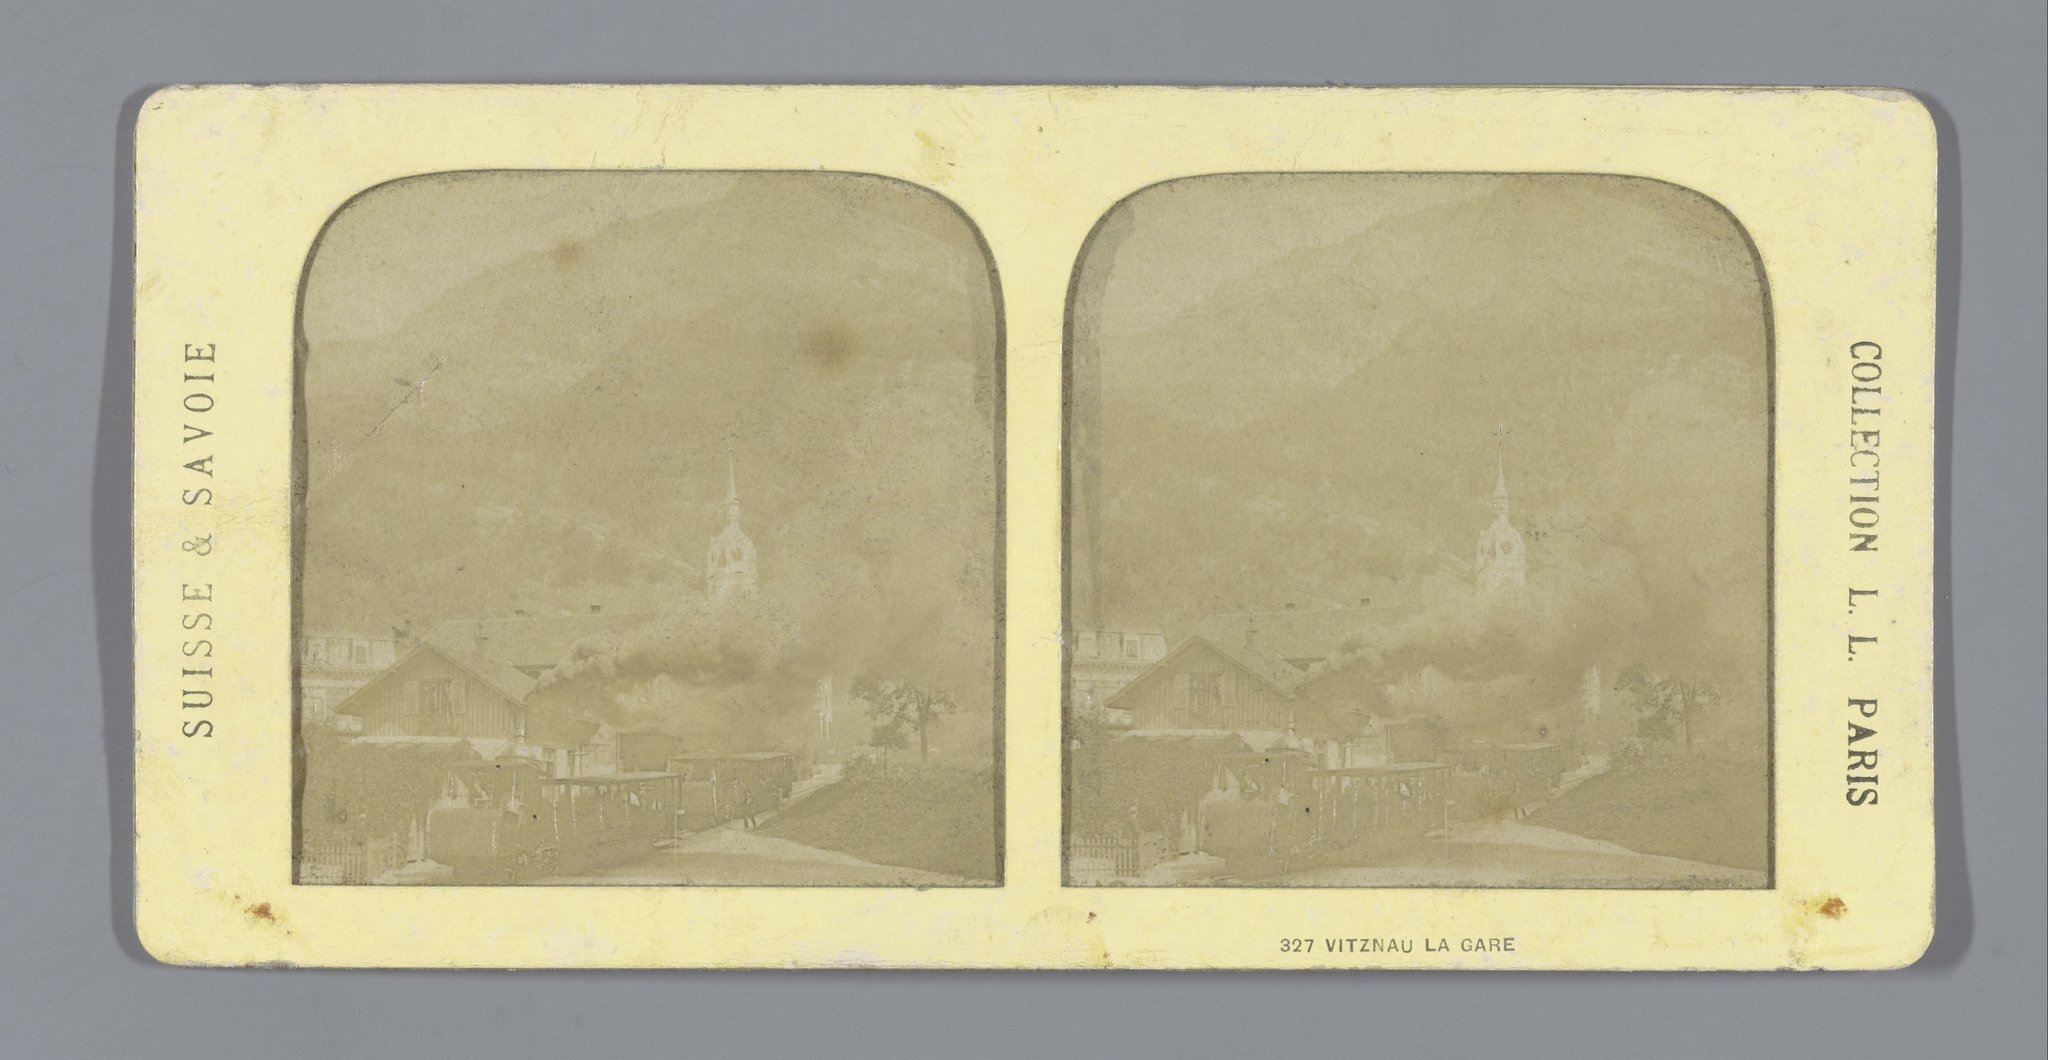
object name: tissue stereograph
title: Vitznau la Gare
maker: Anonymous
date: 1864-1875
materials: cardboard, paper, photographic support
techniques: albumen print, cutting, hand coloring, perforating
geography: vitznau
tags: village, station; shelter (railway, tramway), mountains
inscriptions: number: ‘327’